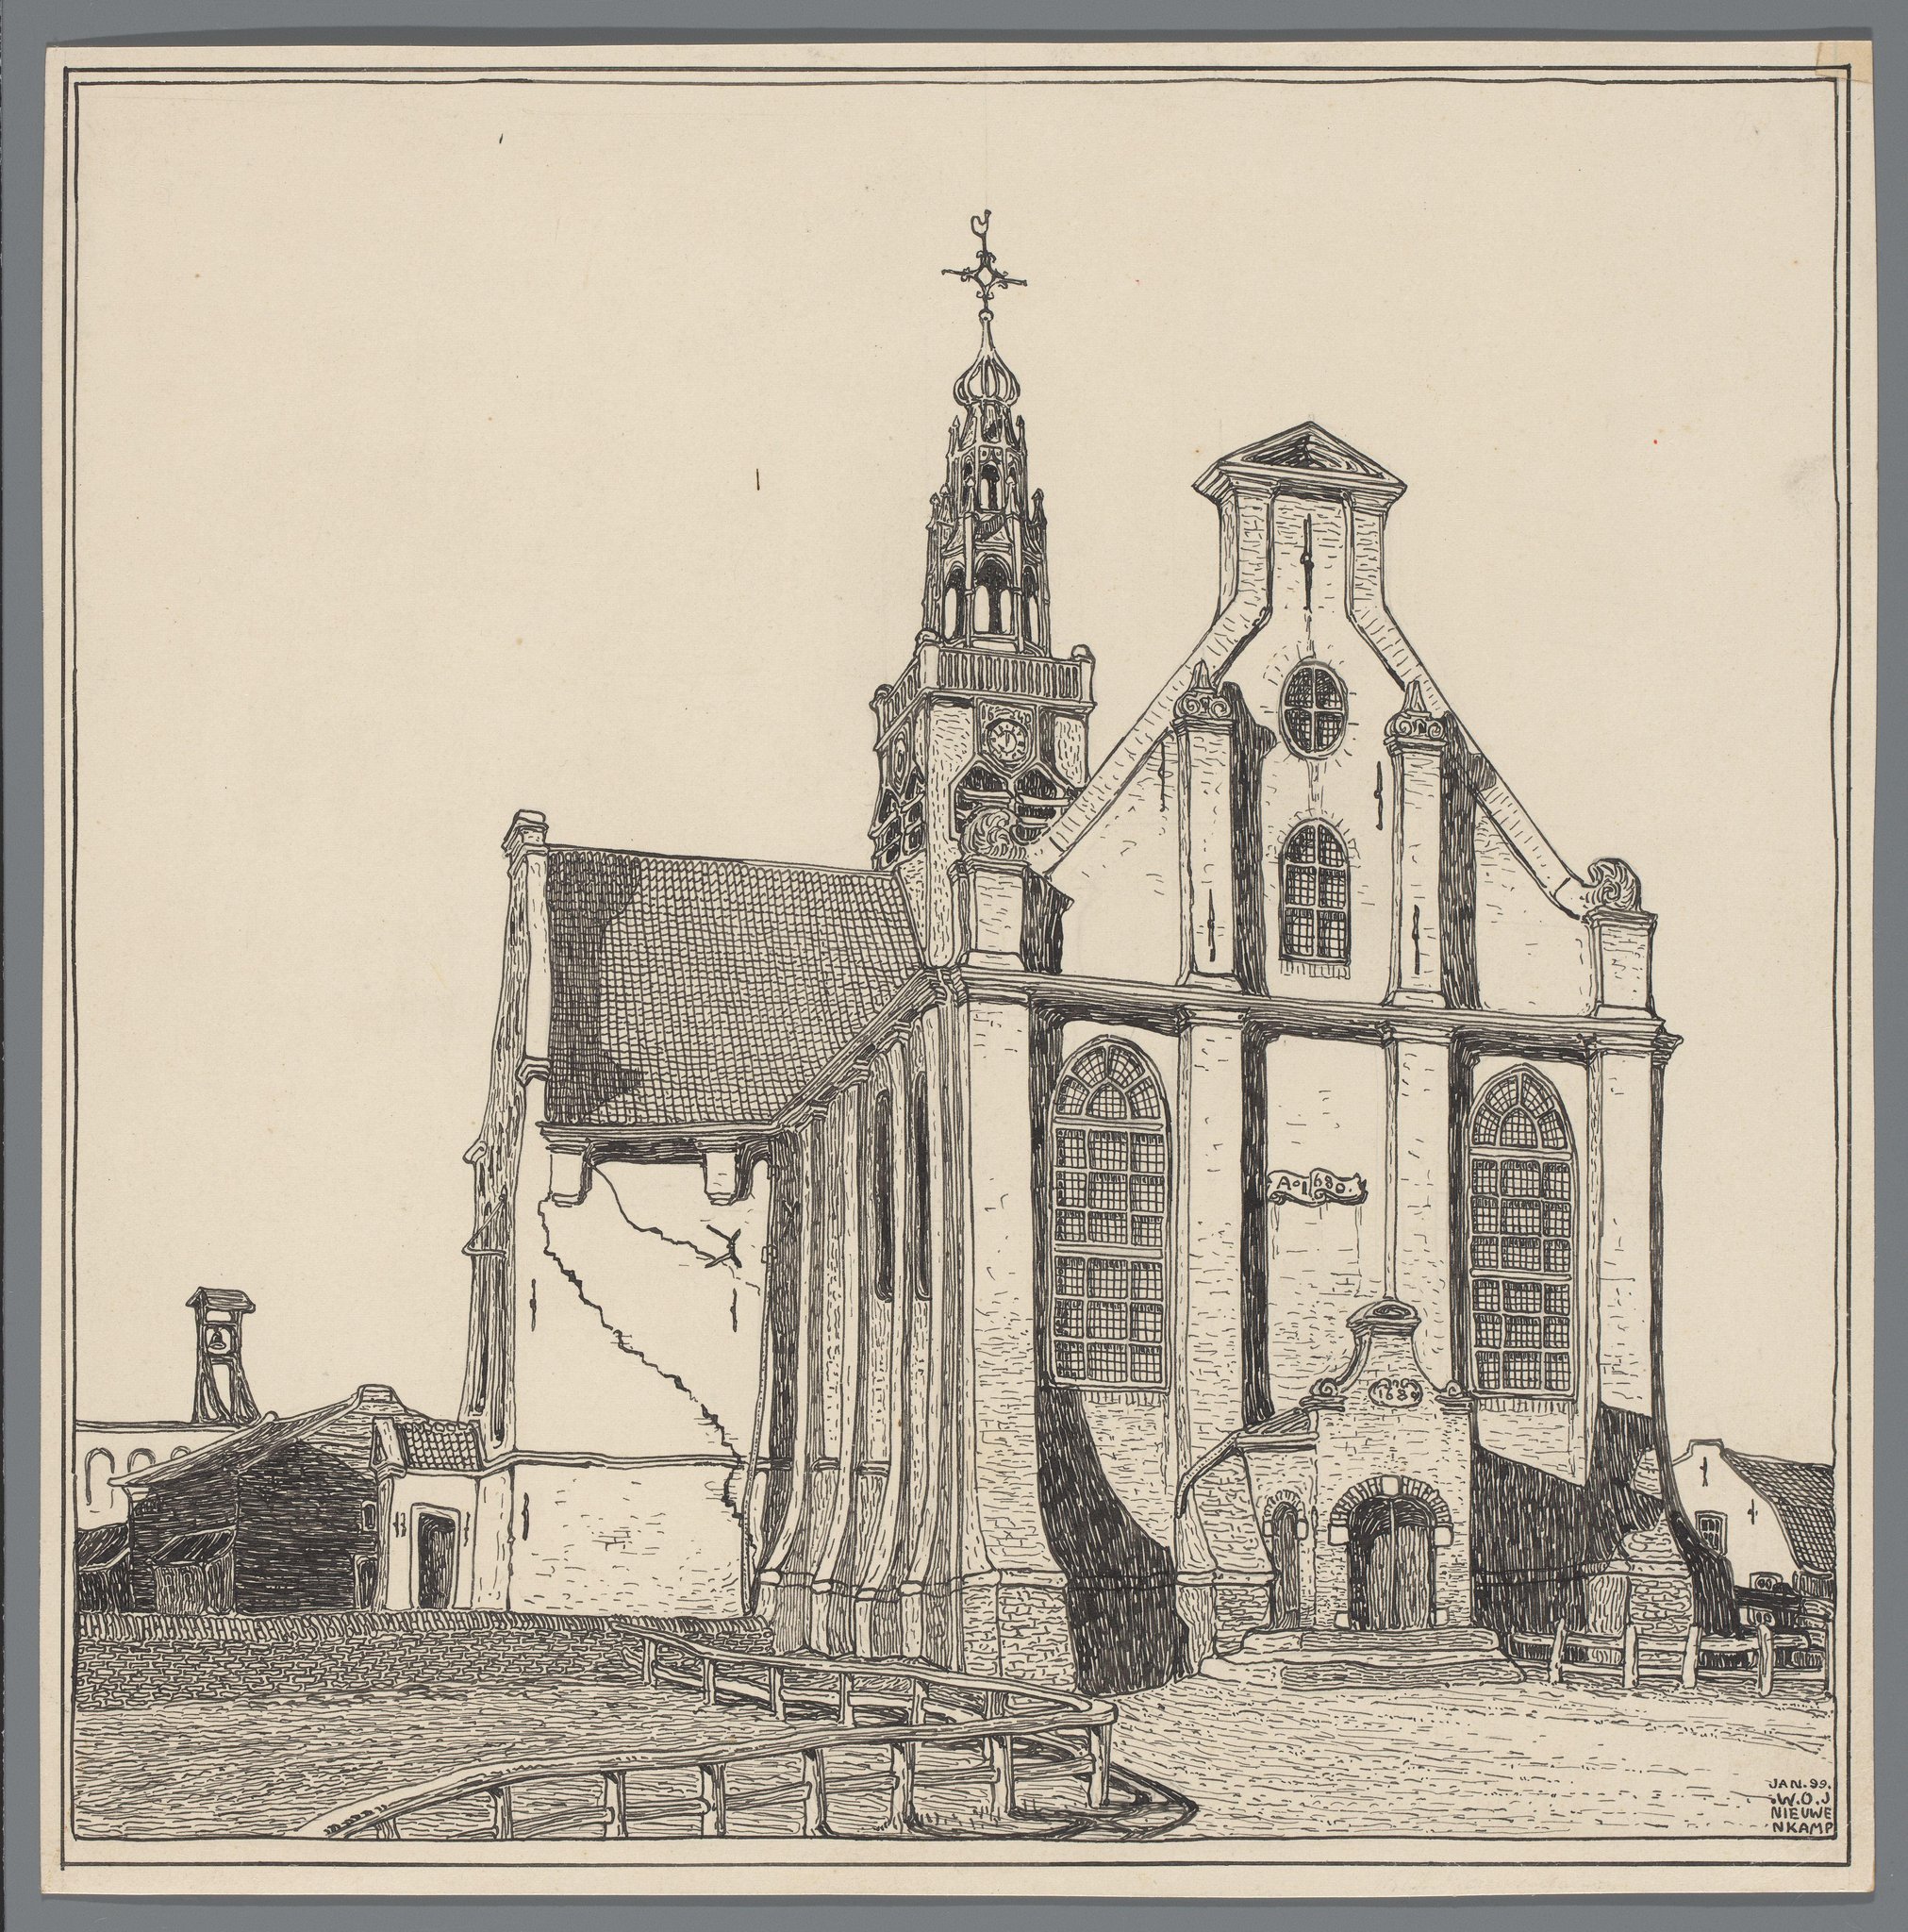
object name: boekillustratie ontwerp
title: Bullekerk te Zaandam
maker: wijnand otto jan nieuwenkamp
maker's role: draughtsman, print maker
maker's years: 1874-1950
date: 1801-1899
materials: ink, paper, pencil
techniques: pen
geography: zaandam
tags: church (exterior)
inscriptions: number: ‘23’